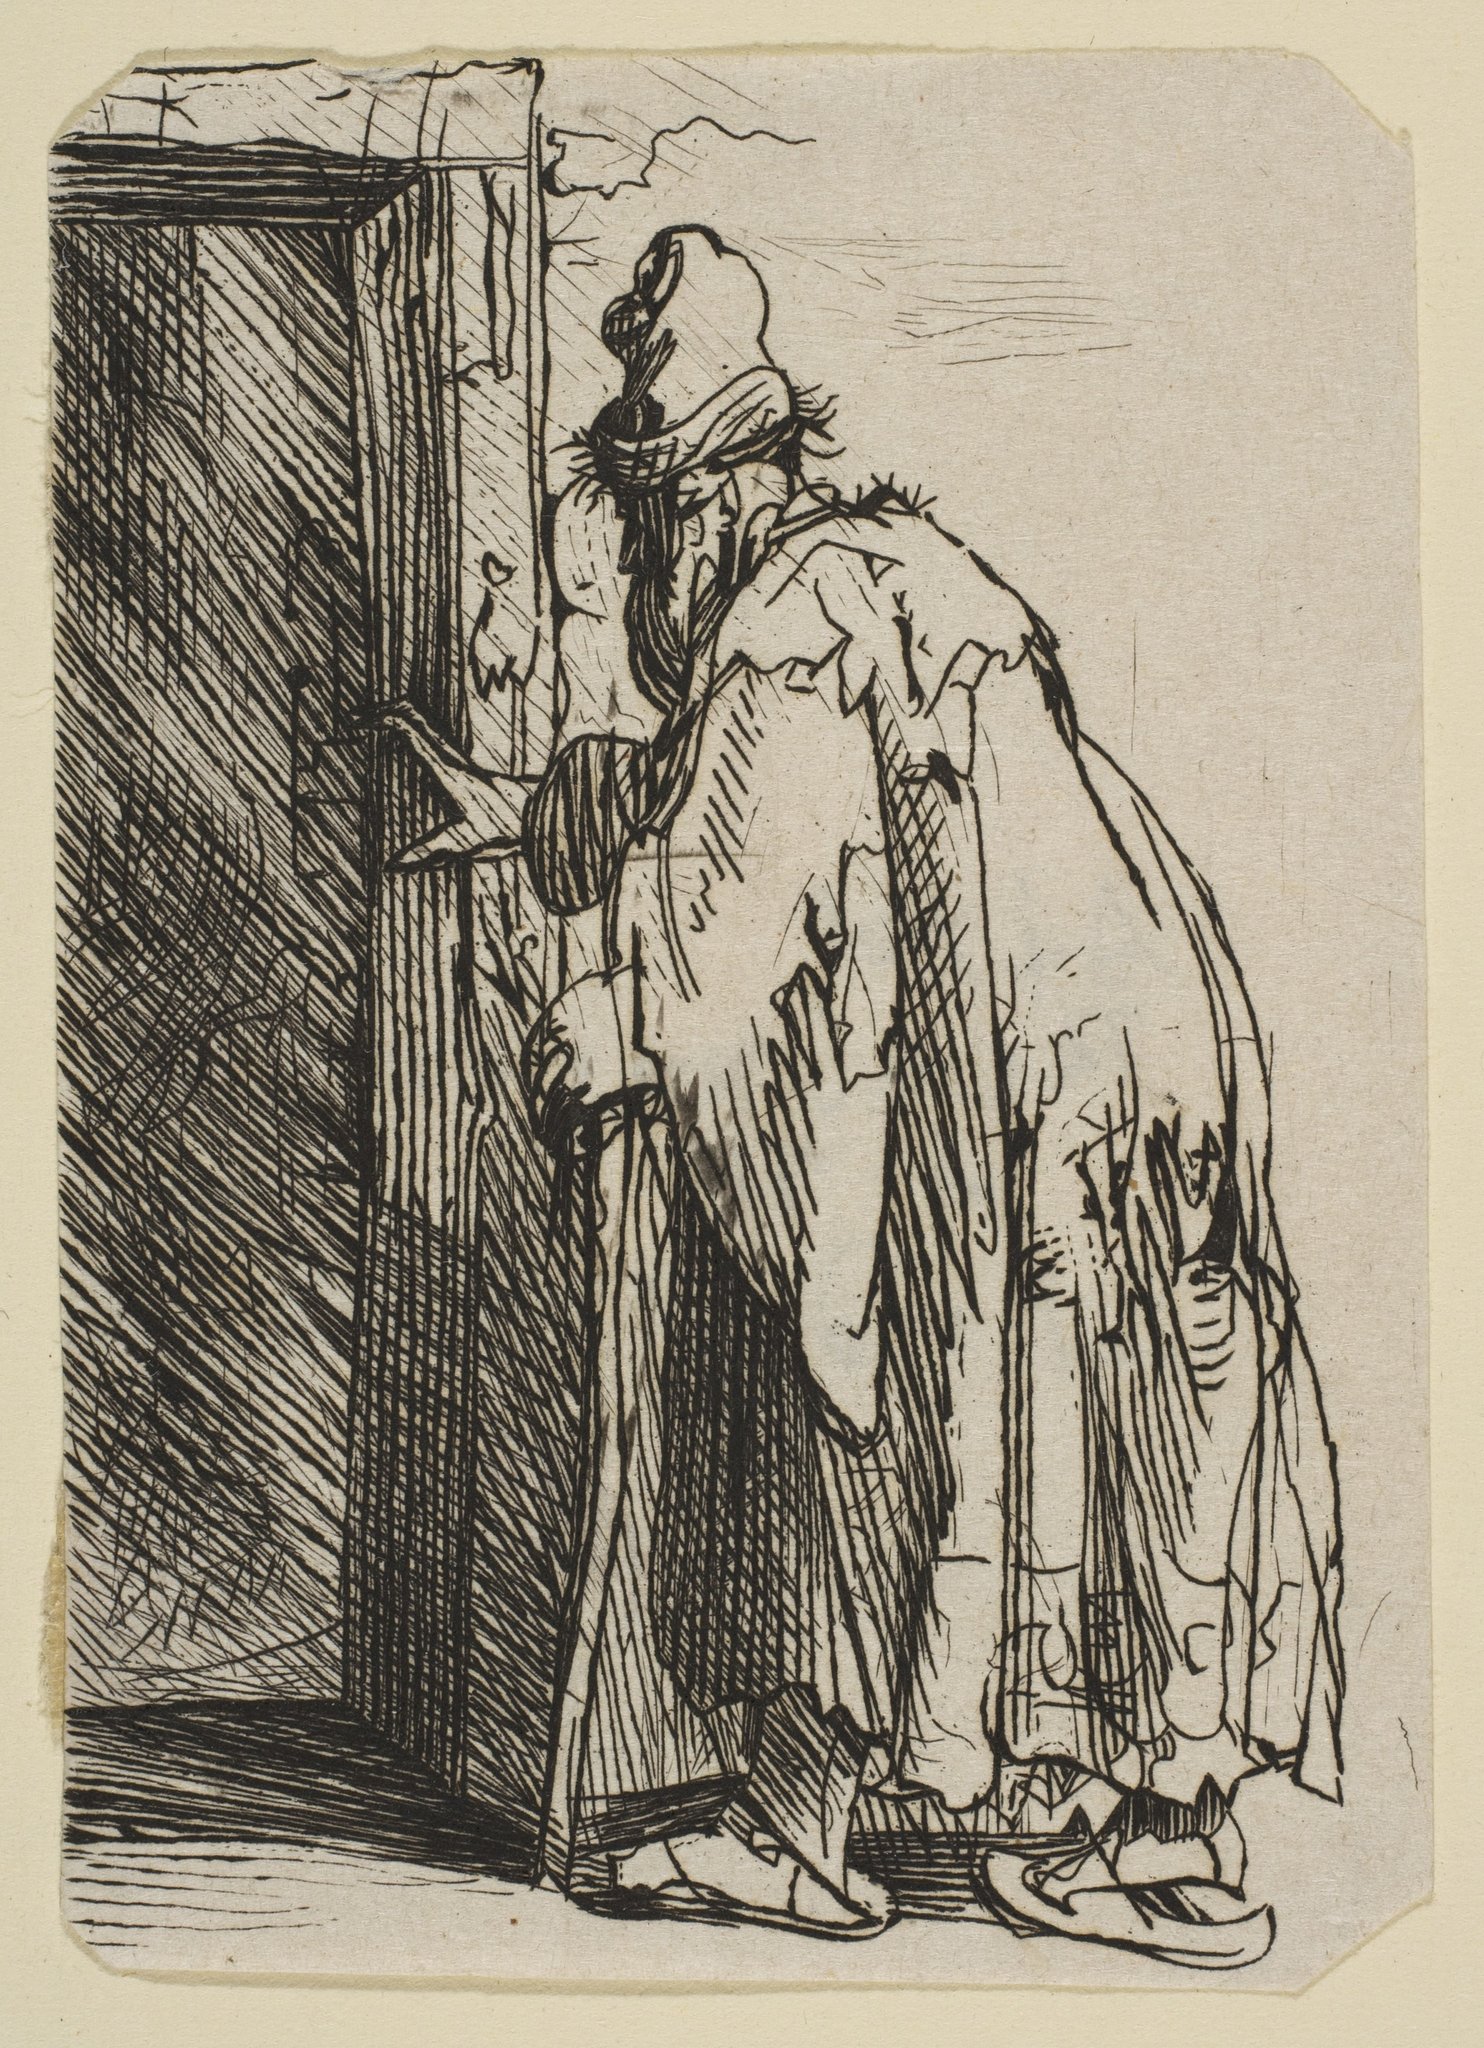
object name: print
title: The Blindness of Tobit: A Sketch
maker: william james smith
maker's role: artist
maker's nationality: british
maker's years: 1824-1826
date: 1825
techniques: etching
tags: men